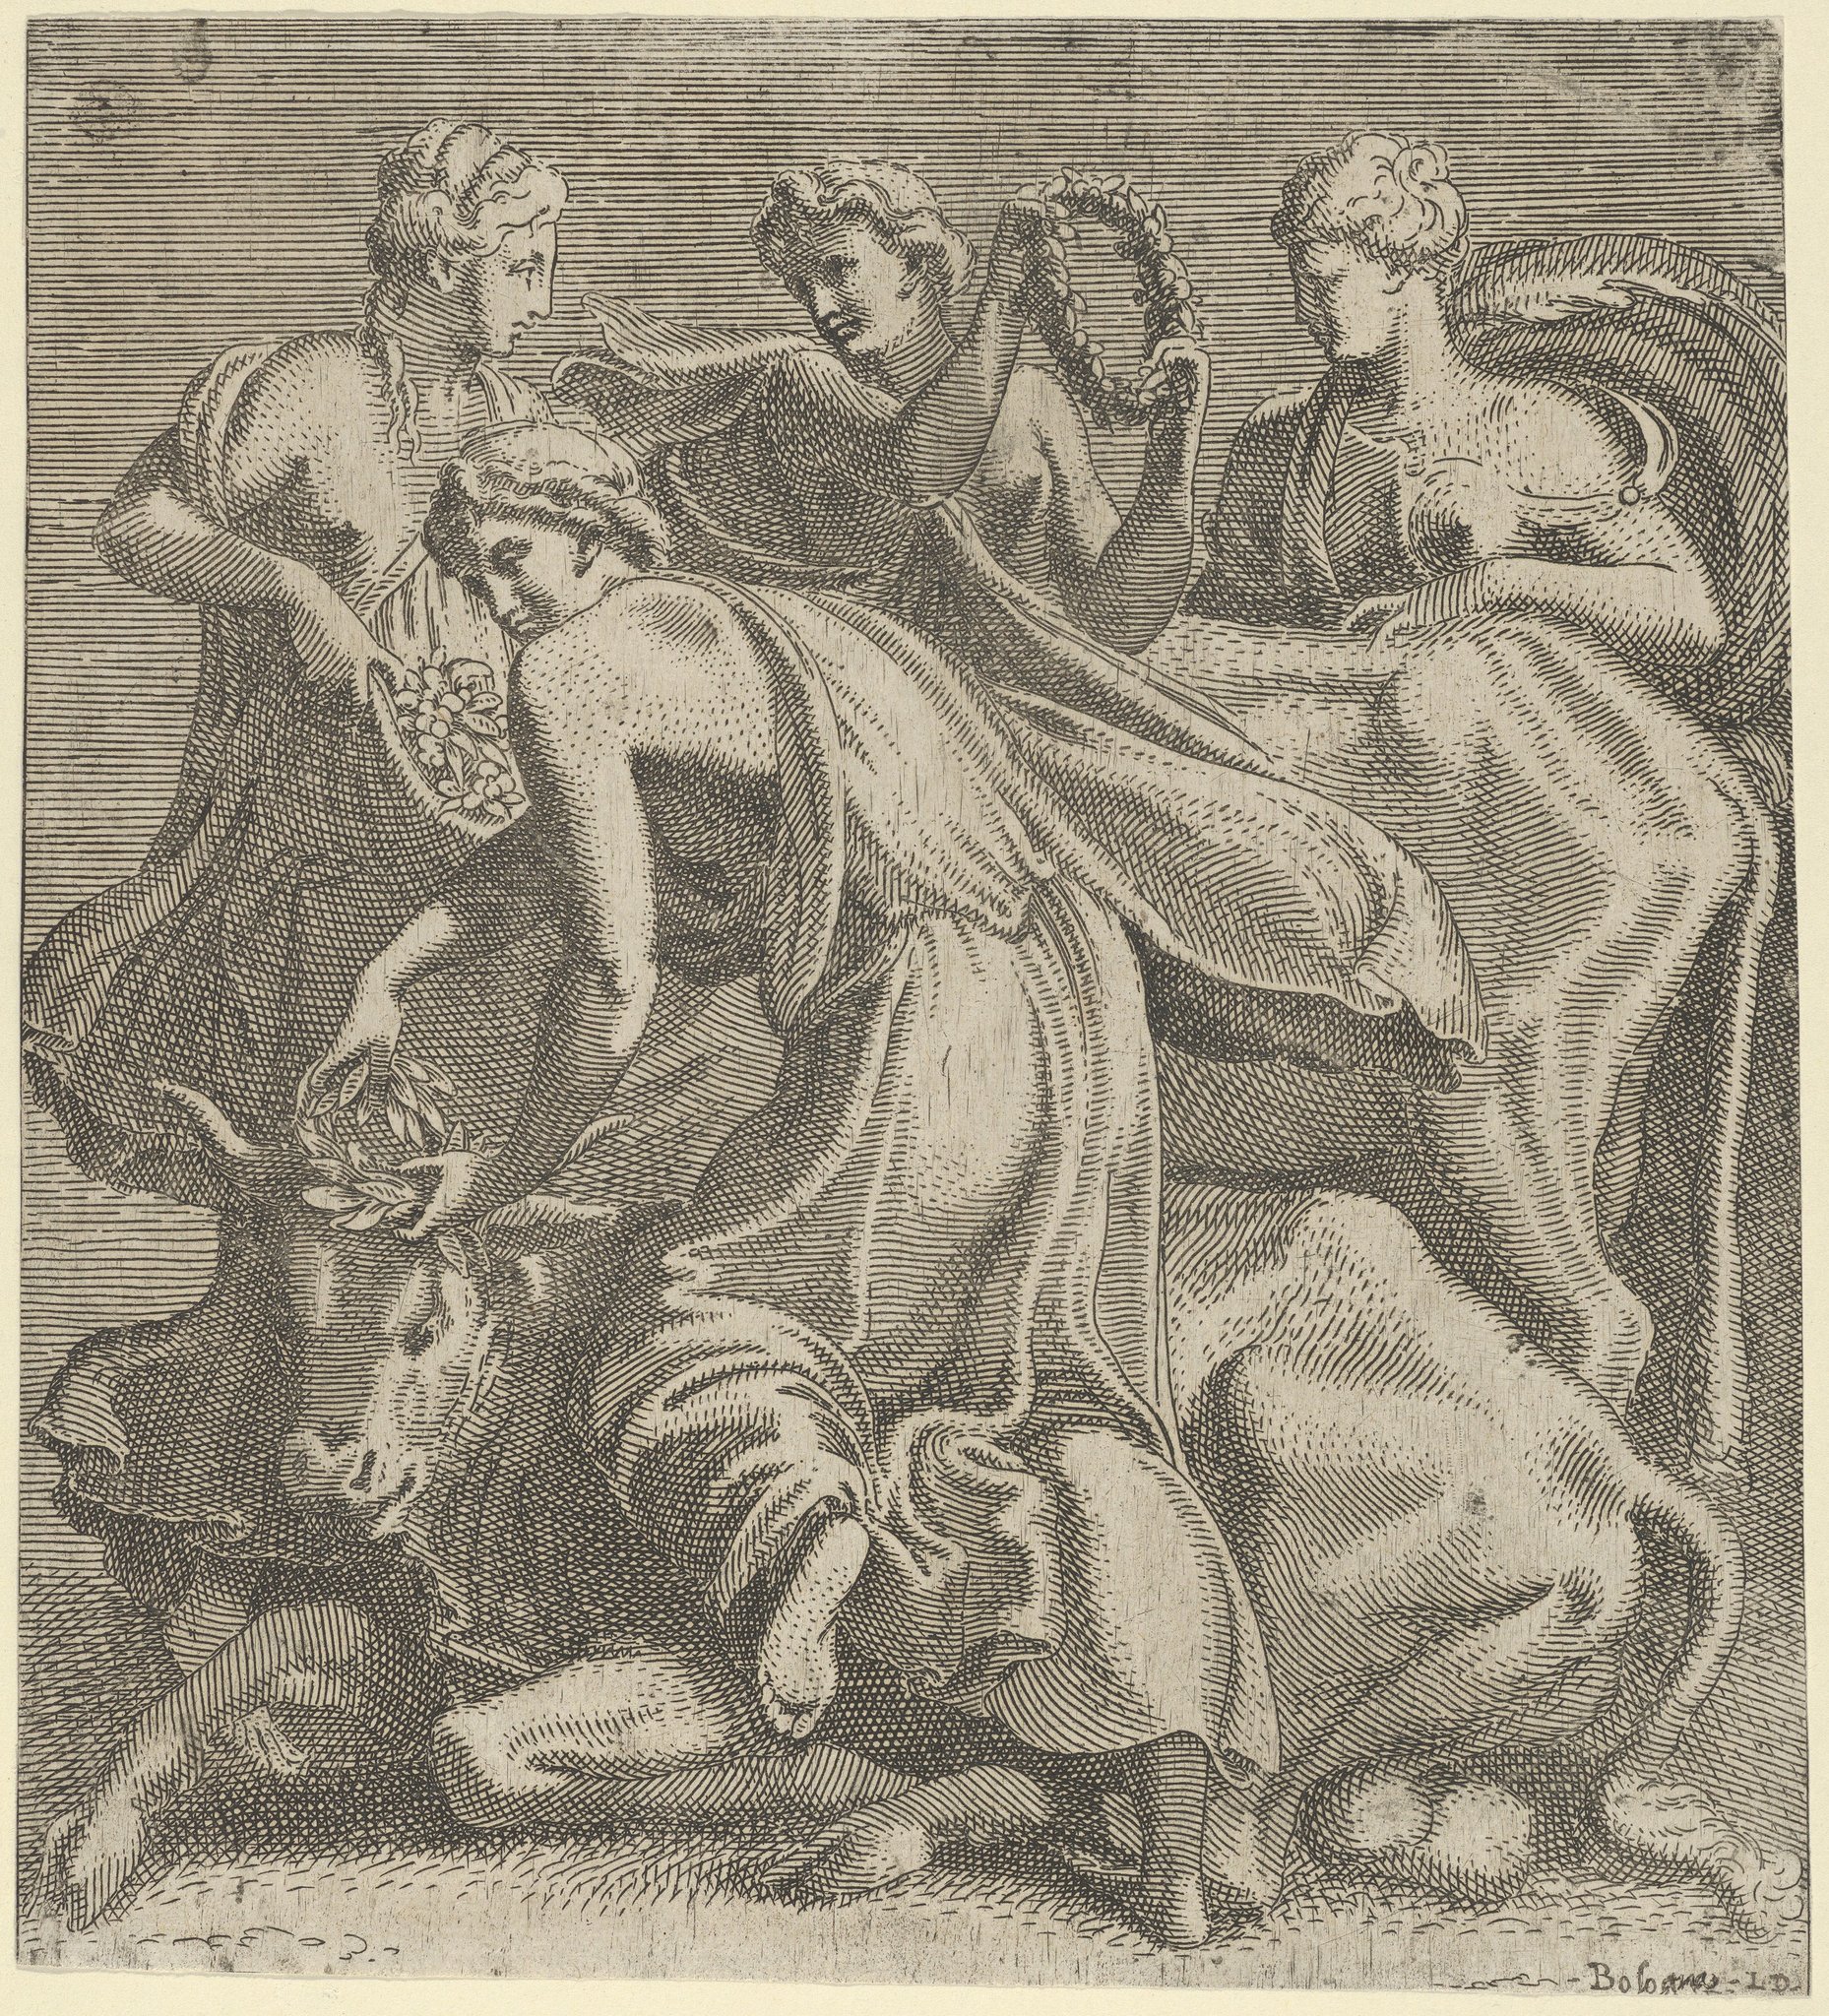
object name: print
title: The Rape of Europa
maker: léon davent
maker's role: artist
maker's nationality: french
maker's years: 1540-1556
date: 1542-1545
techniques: etching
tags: women,bulls